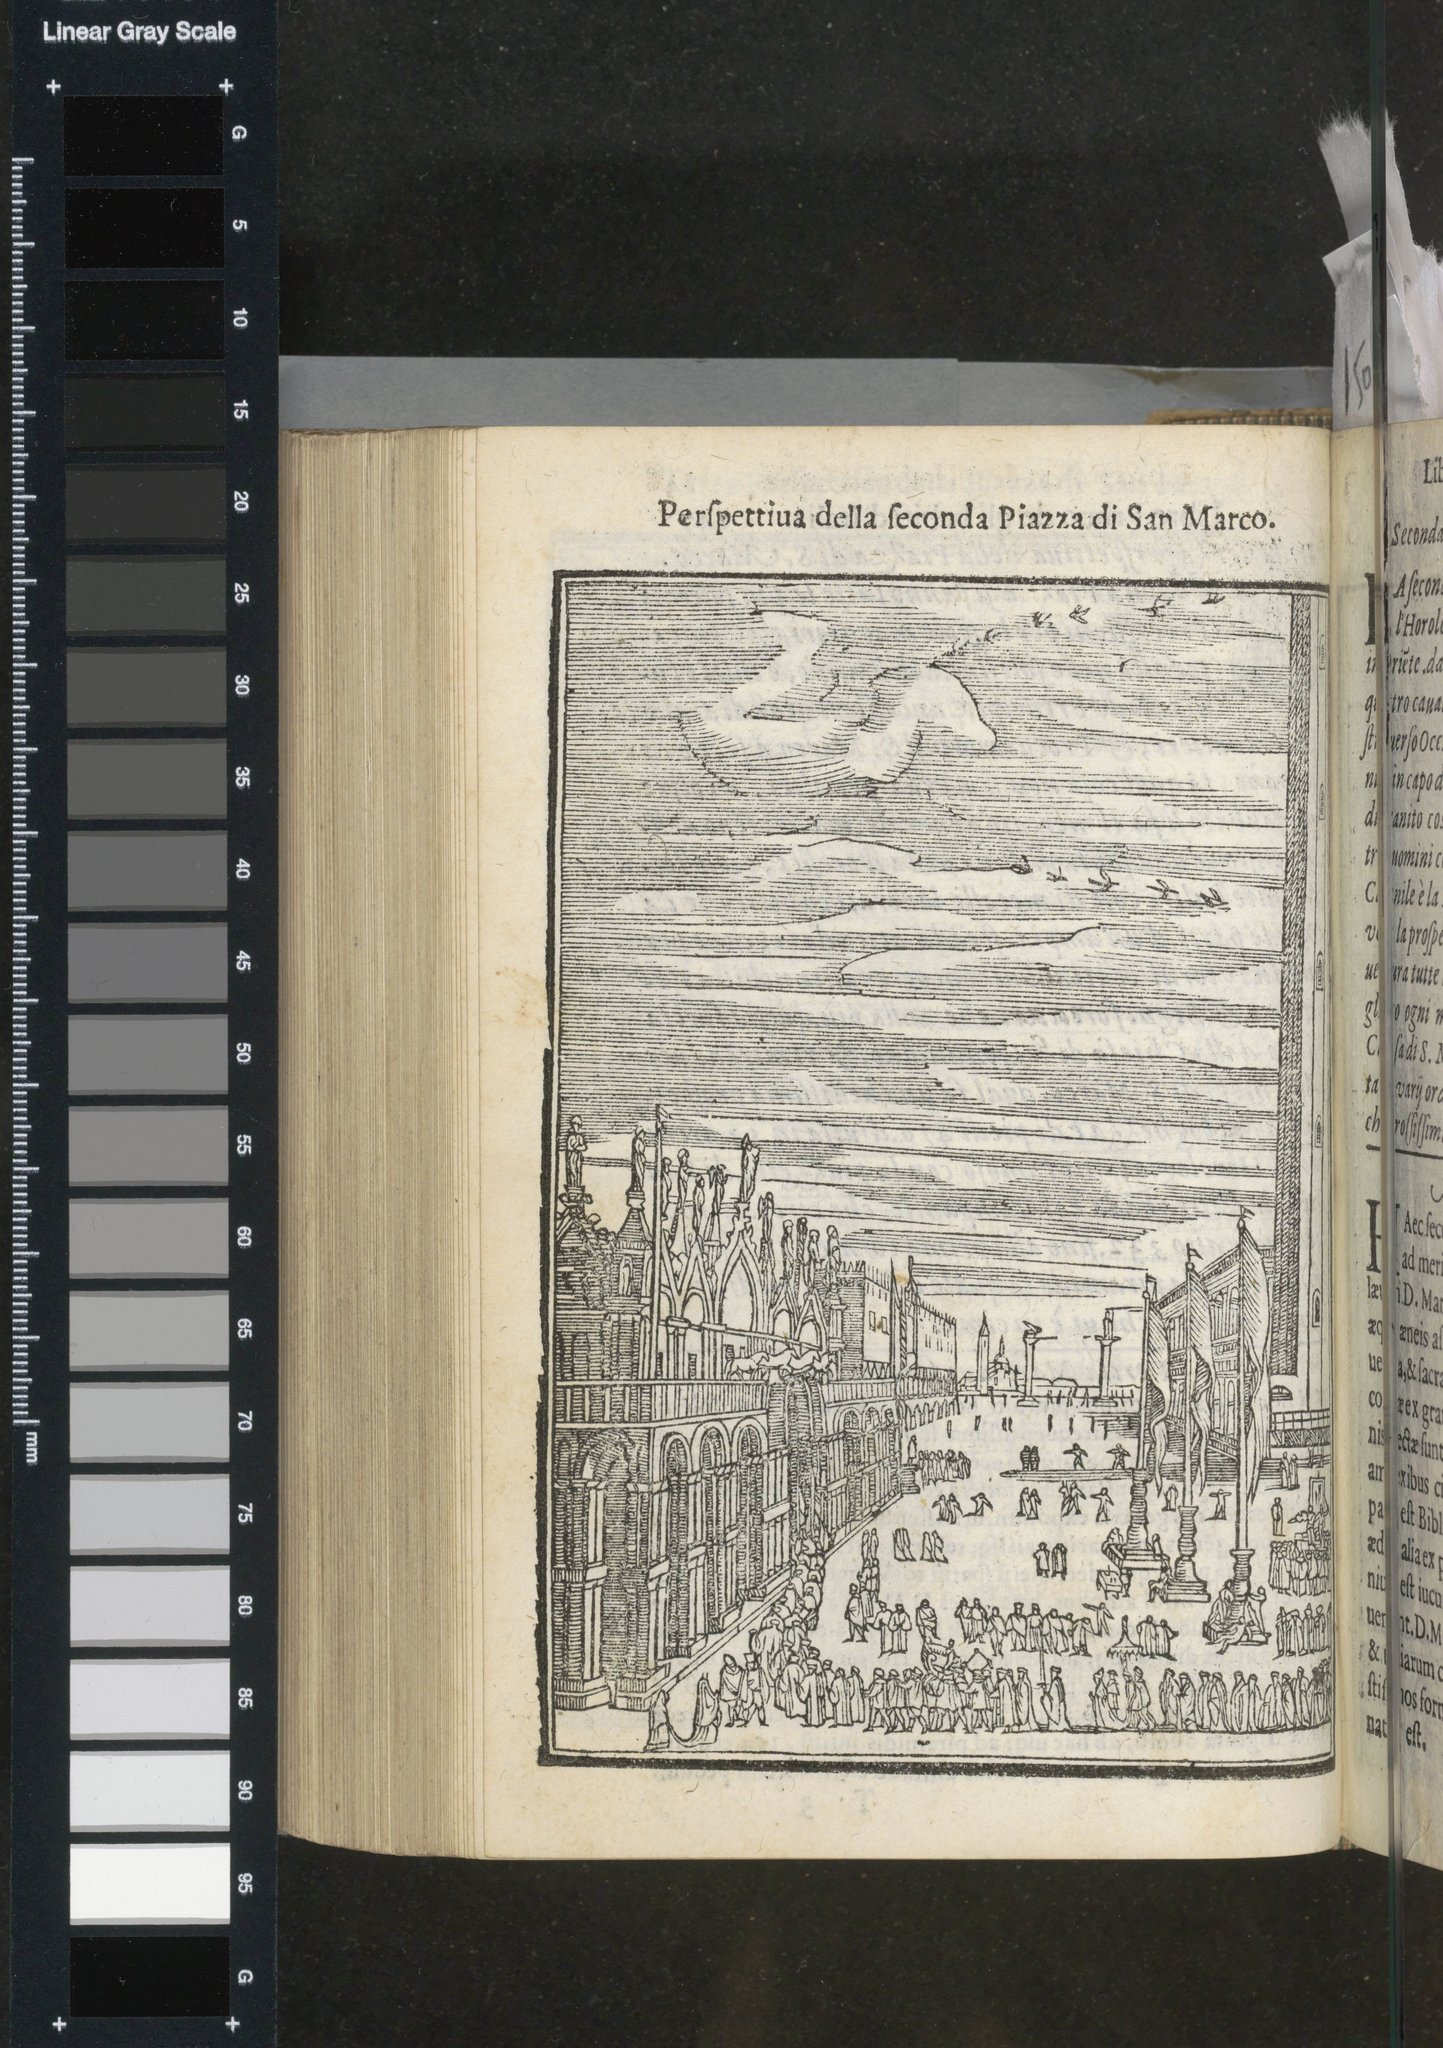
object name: costume print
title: Habiti antichi, et moderni di tutto il mondo...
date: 1598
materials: paper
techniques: woodcut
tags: fashion plates